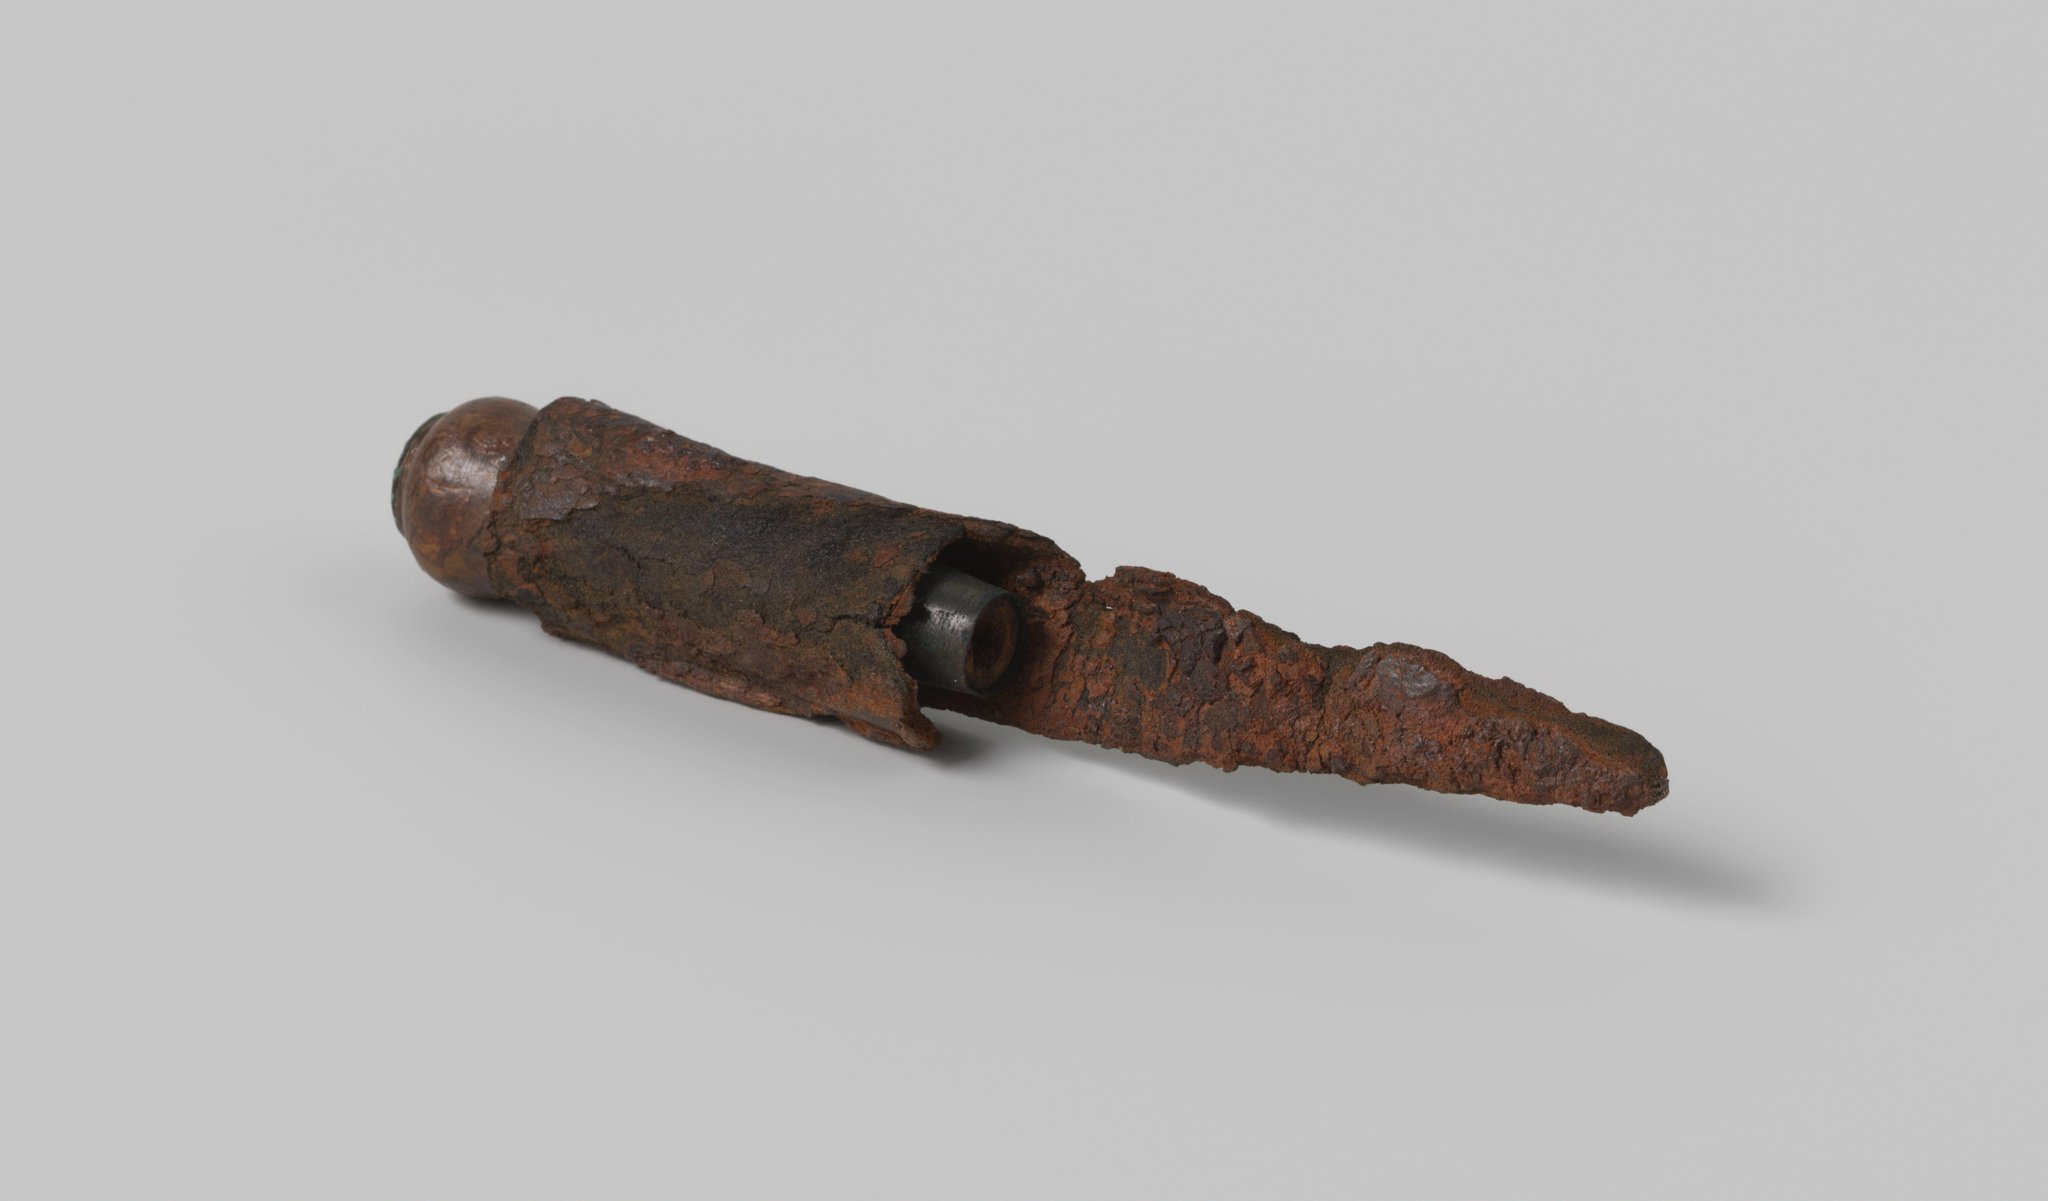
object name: messchede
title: Messchede en messenheft uit het wrak van de Oost-Indiëvaarder Hollandia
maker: Anonymous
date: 1742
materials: bone, leather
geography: netherlands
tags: verenigde oostindische compagnie, hollandia (schip), annet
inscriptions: : ‘STAD UTRECHT 1742’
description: Knife, handle in scabbard, cylindrical: tapering; handle, slightly bulbous flat upper end, end mounted with coin, obverse eroded, reverse relieved inscription [STAD UTRECHT 1742], ferrule at lower end: fragm of (le) scabbard, eroded, circular in section, pointed tapering lower end.